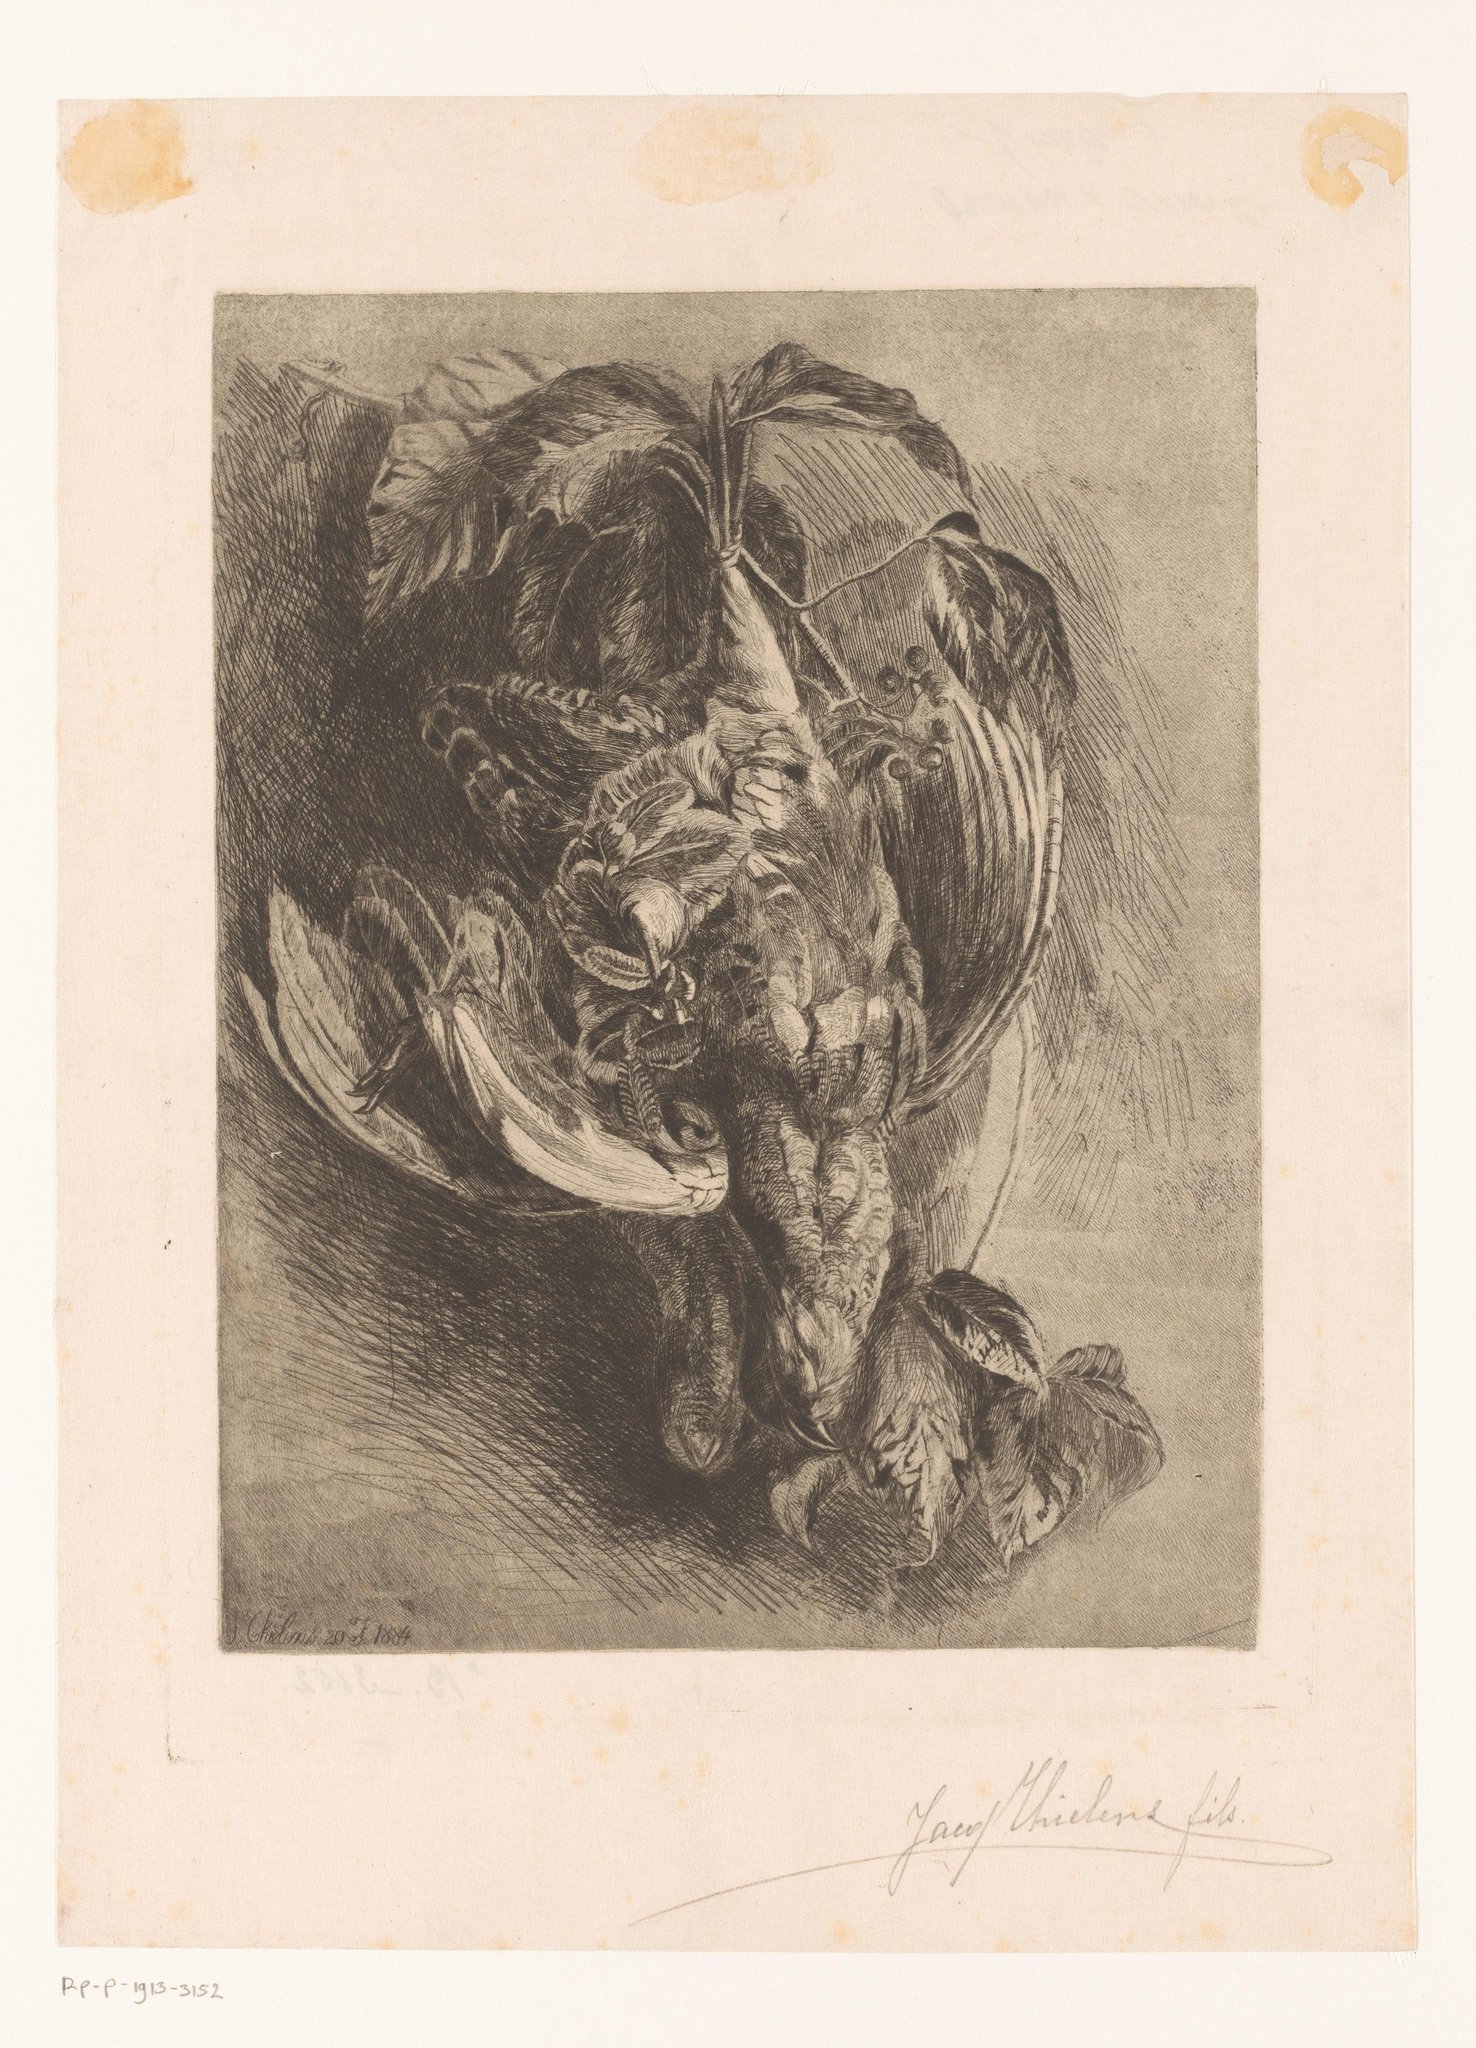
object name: print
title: Dode vogels hangend aan een tak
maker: jacques thielens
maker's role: print maker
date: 1884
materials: paper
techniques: drypoint, etching, intaglio, retroussage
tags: birds, hunting trophies, kitchen-interior with foodstuffs in foreground (dutch: 'keukenstuk')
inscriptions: mark: ‘Antwerpsche Etsers 1880’, collector's mark: Lugt 2228